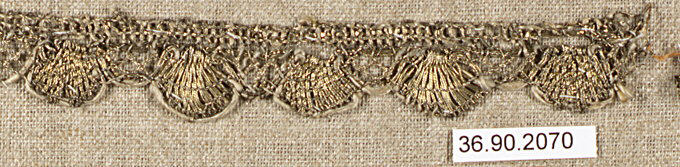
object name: piece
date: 1801-1900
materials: metal thread, silk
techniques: lace